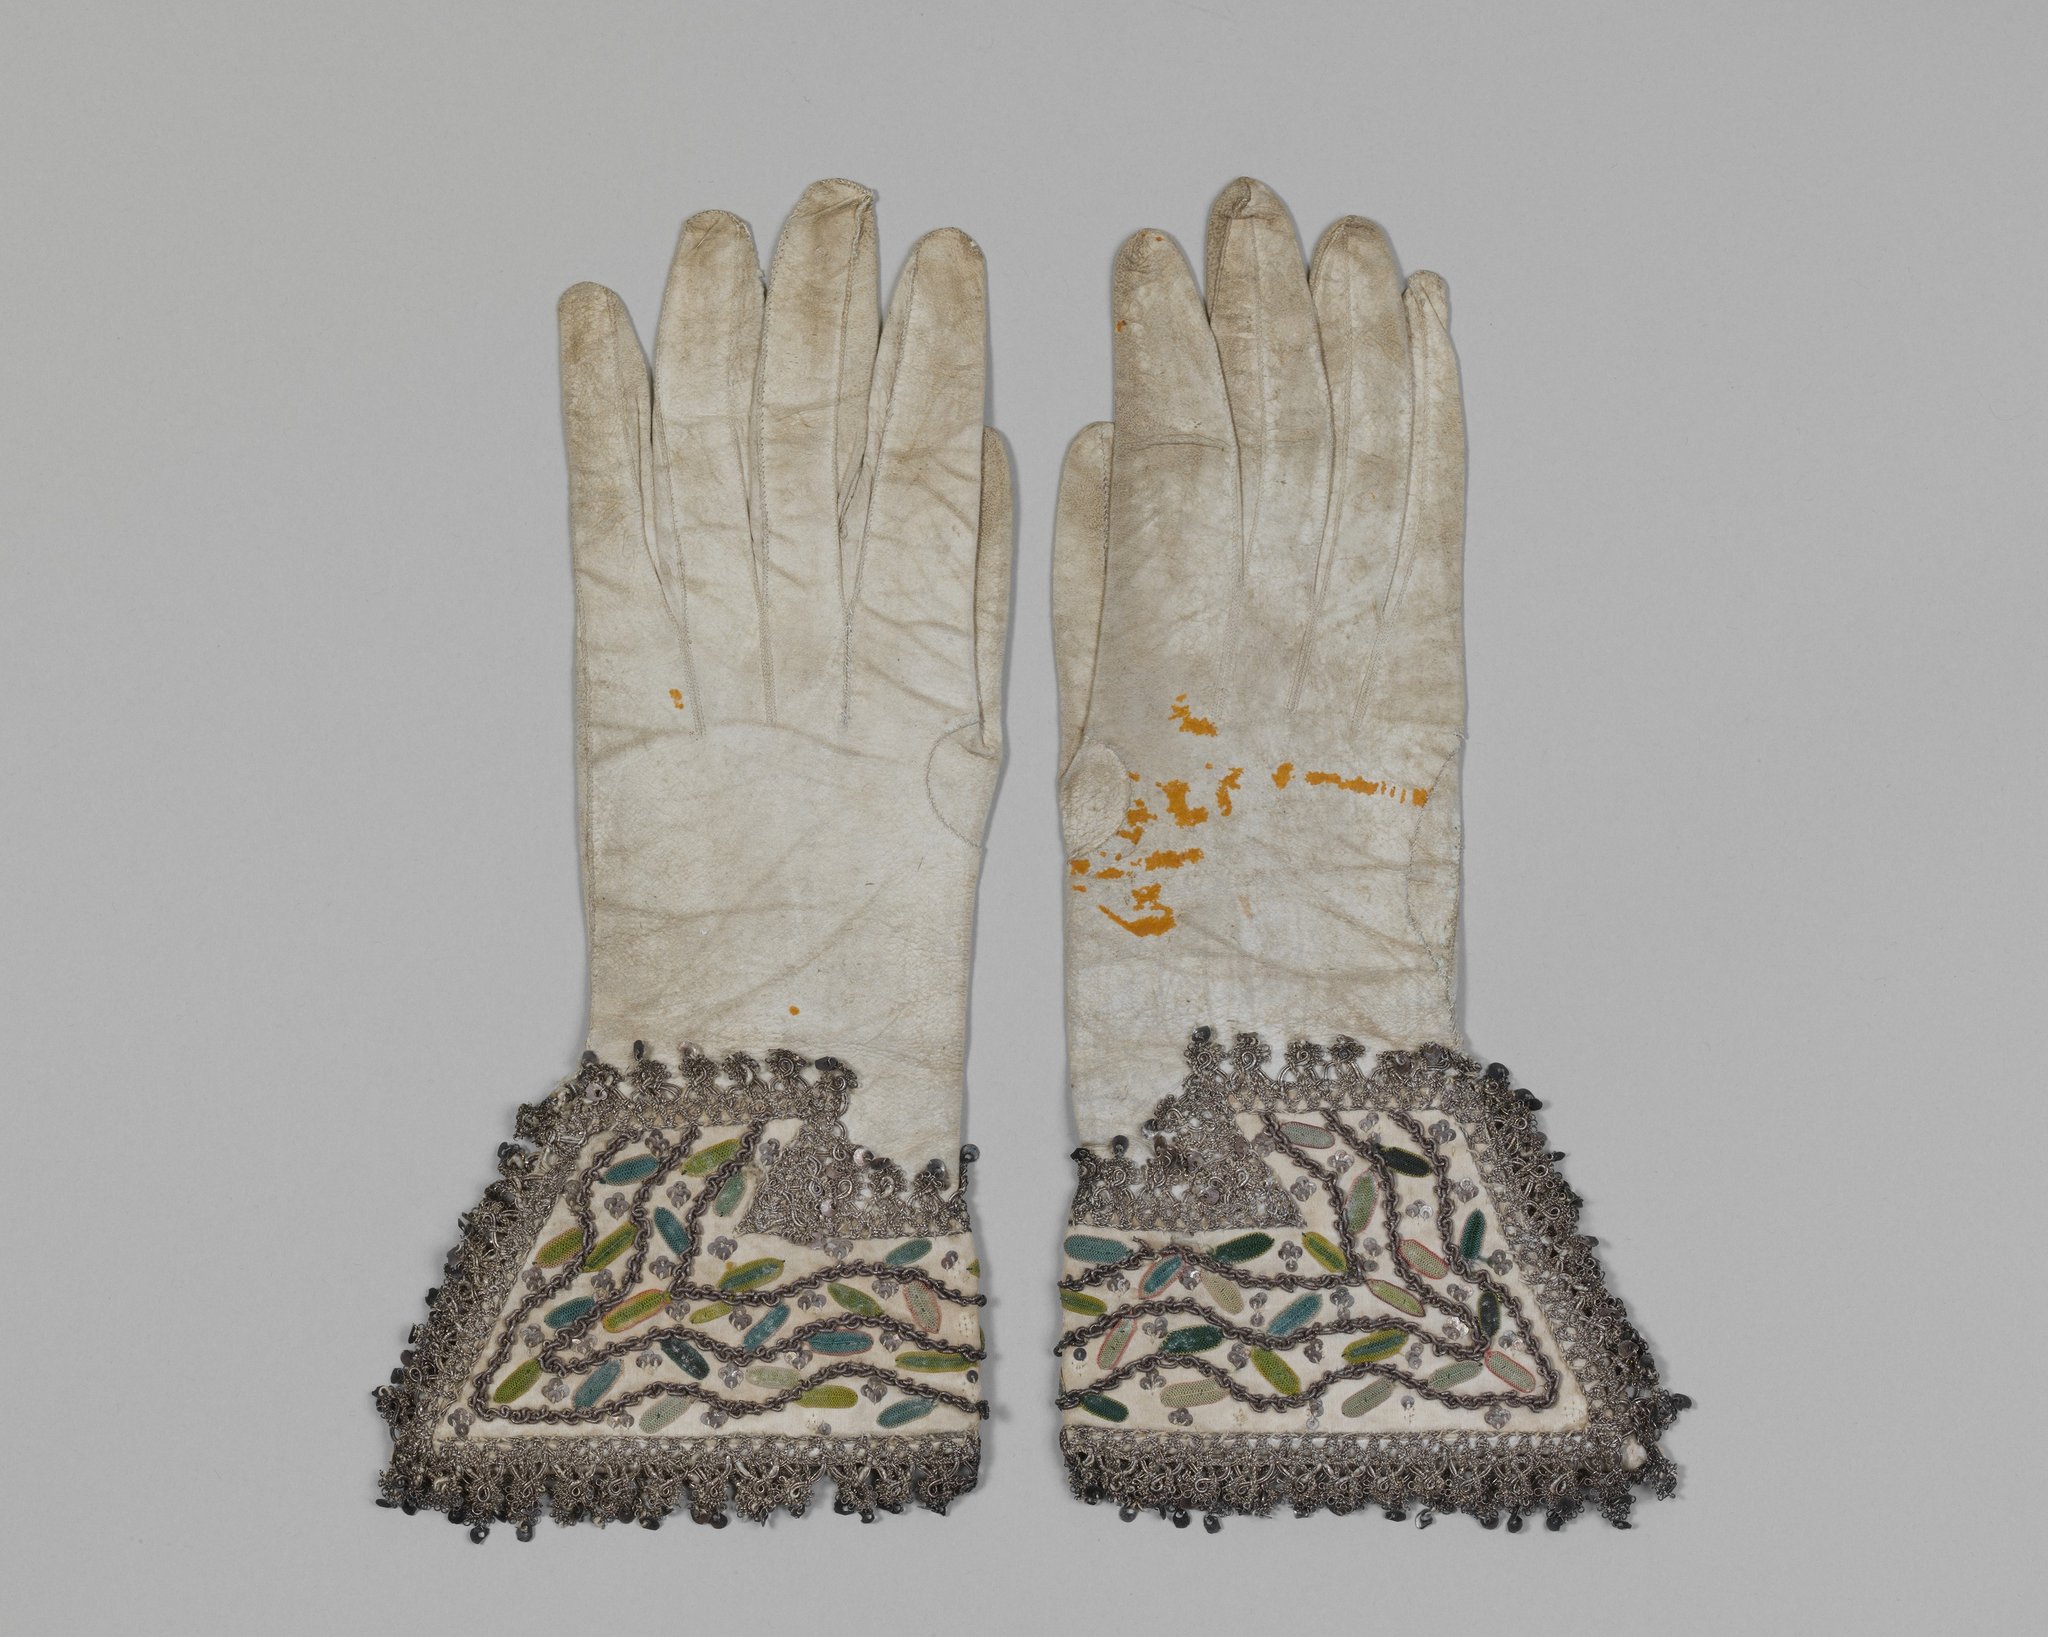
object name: glove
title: Pair of gloves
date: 1626-1650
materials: lace, leather, textile